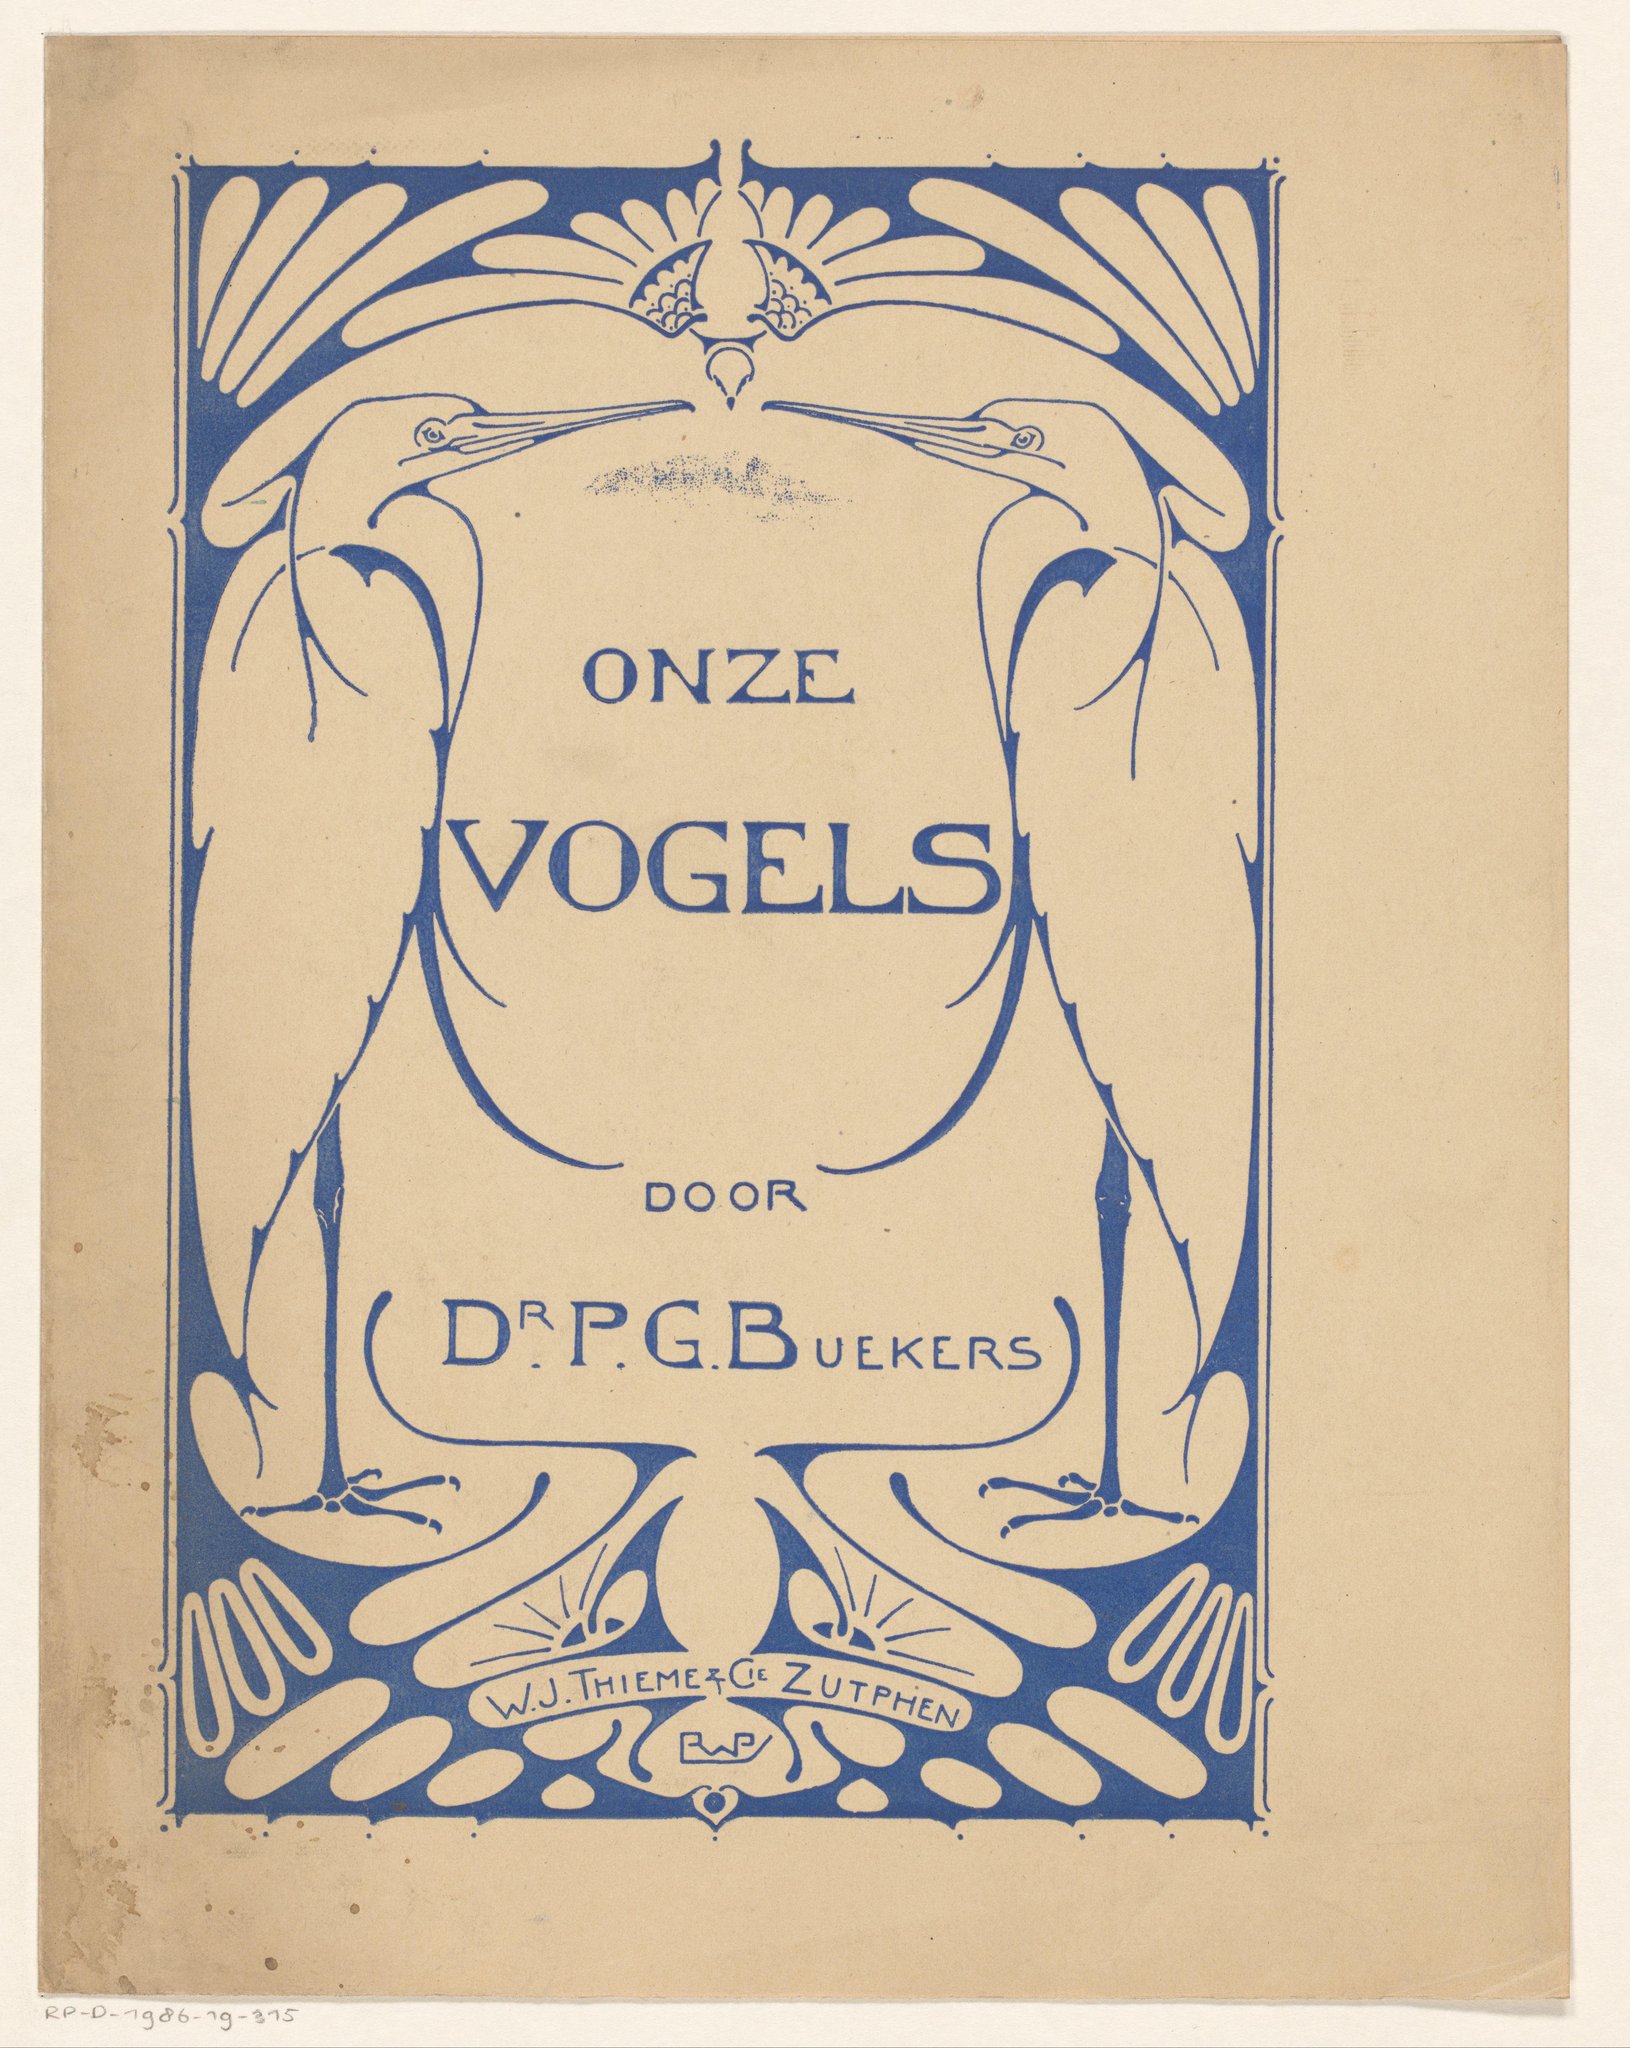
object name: print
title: Bandontwerp voor: P.G. Buekers, Onze vogels, 1900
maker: reinier willem petrus de vries (1874-1953)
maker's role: draughtsman, print maker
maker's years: 1874-1953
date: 1900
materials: paper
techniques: printing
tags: birds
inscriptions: collector's mark: ‘R:MVS.’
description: Bandontwerp met twee vogels die aan weerszijden van de boektitel met de snavel naar elkaar gericht staan.